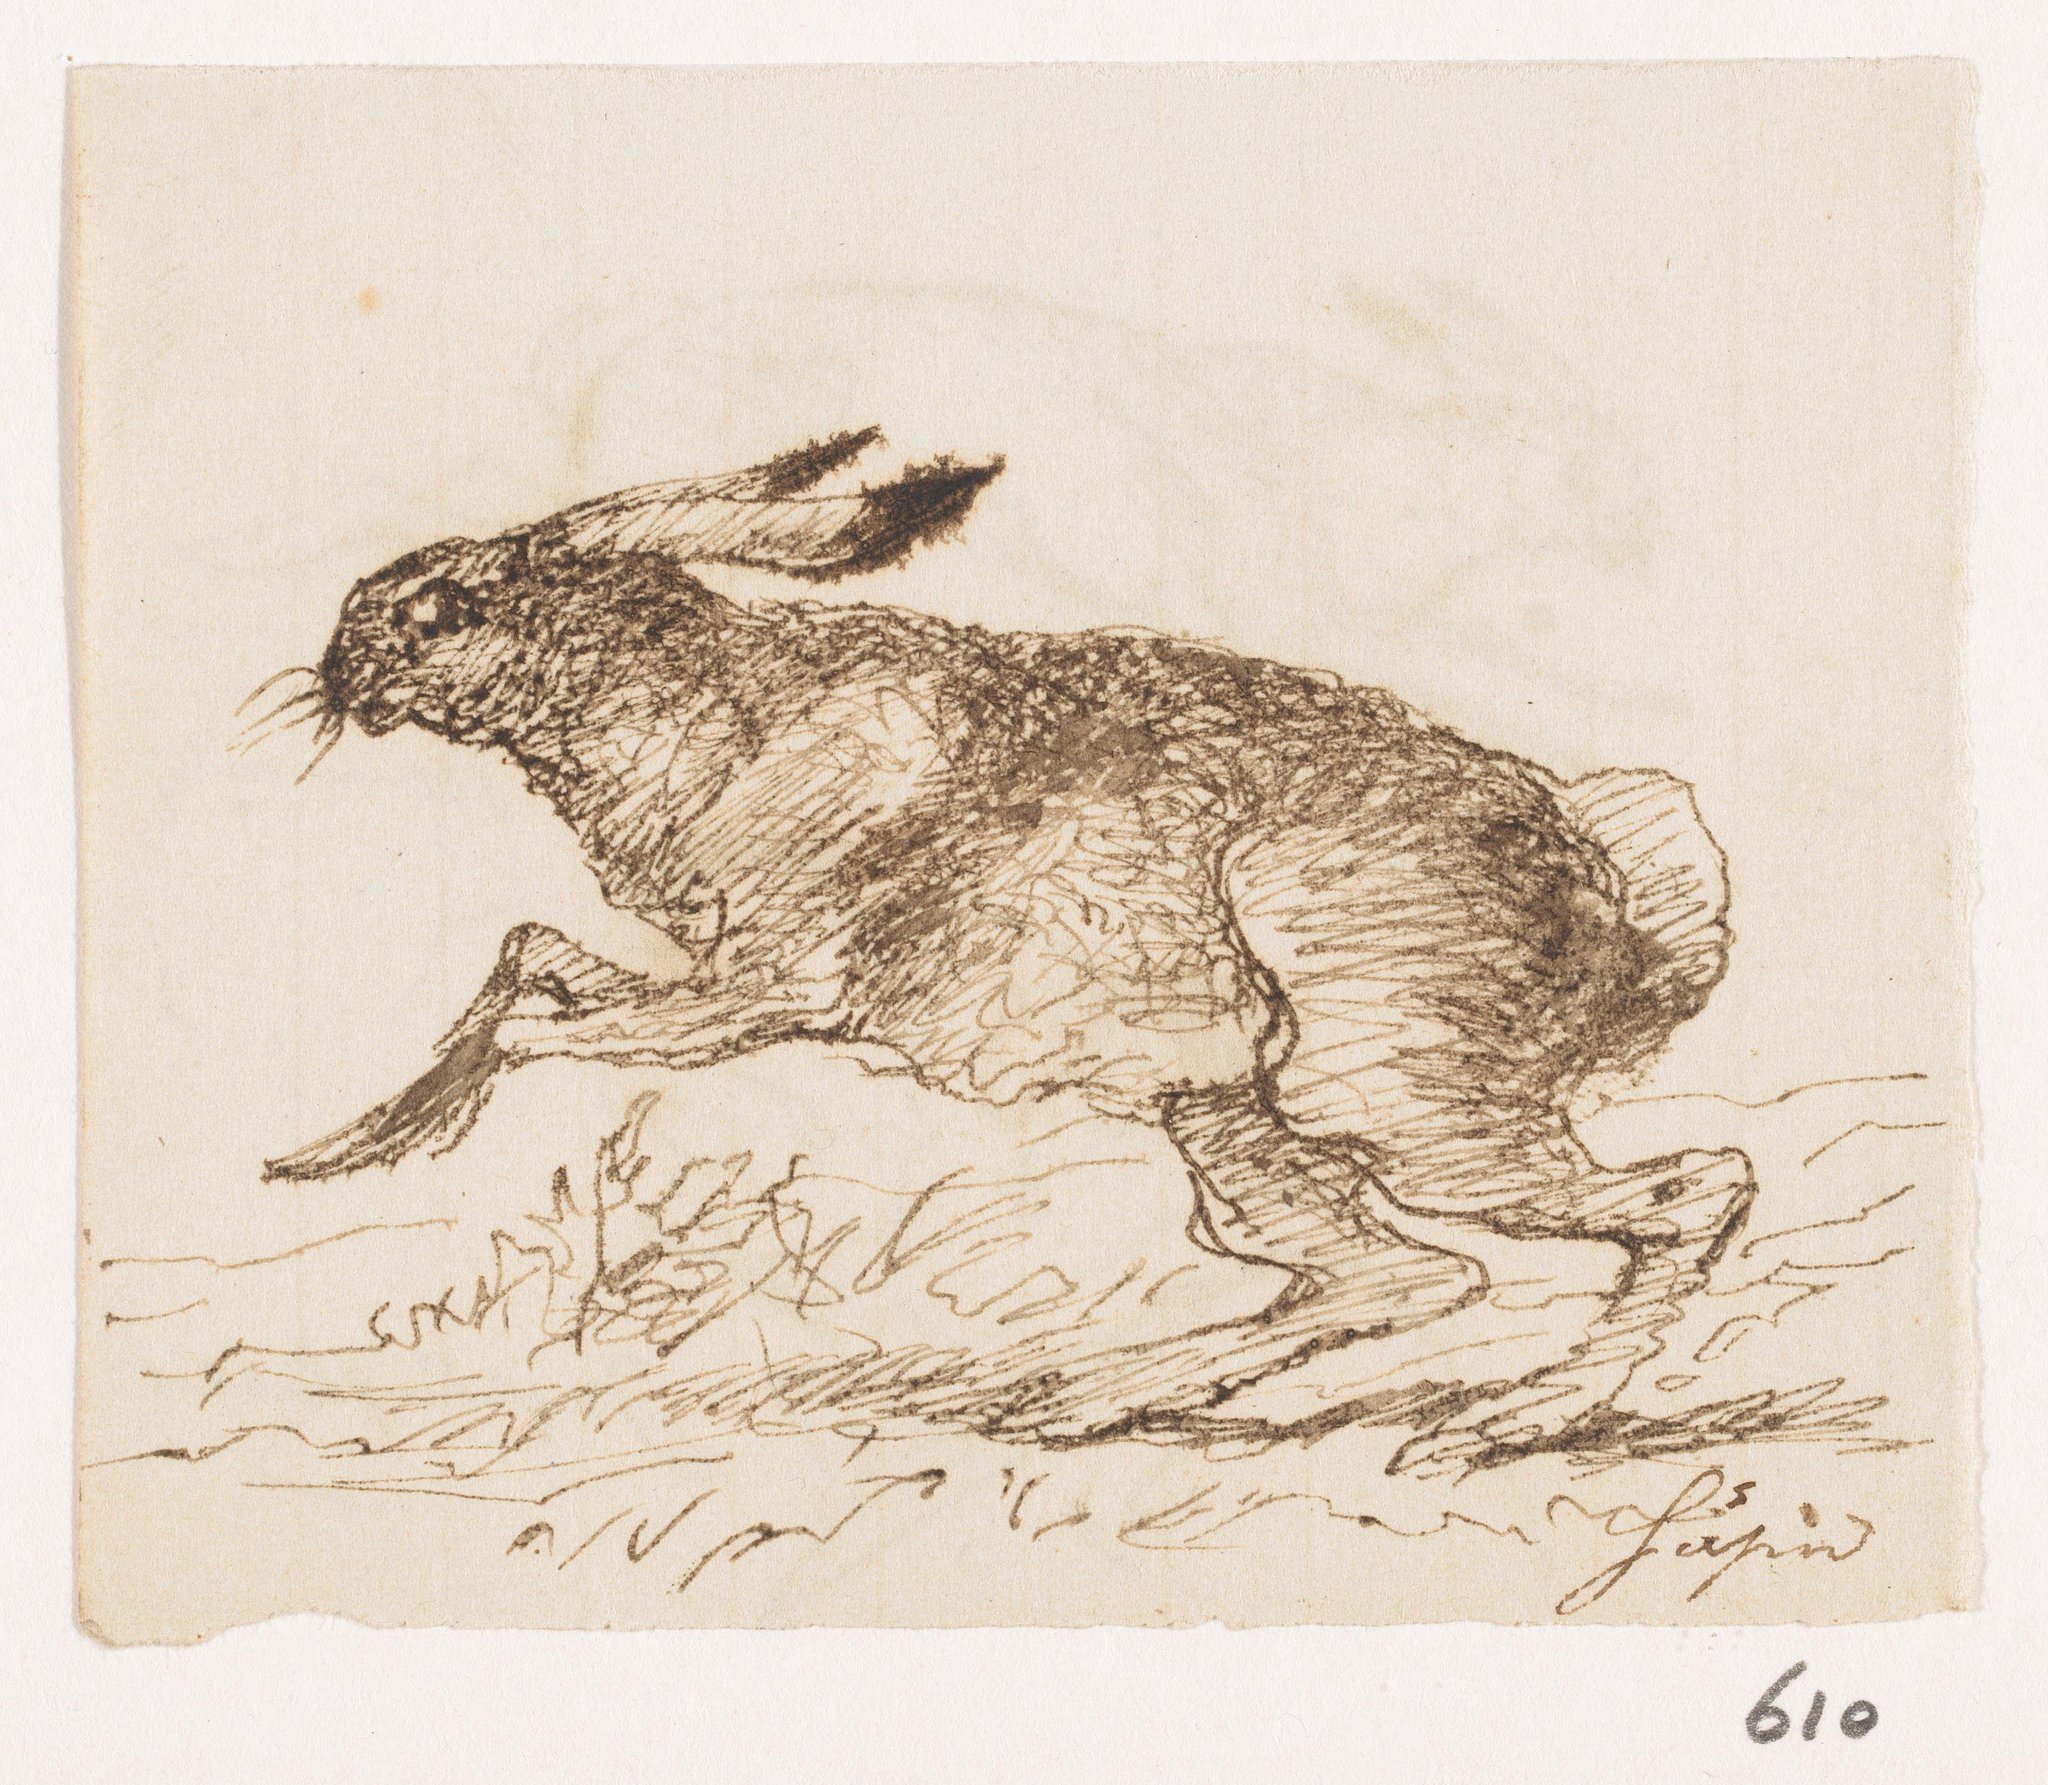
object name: drawing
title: Lapin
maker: johannes tavenraat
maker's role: draughtsman, painter, print maker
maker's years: 1809-1881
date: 1840-1880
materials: ink, paper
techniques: pen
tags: rodents: hare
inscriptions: signature: ‘Tavenraat’, collector's mark: Lugt 2228